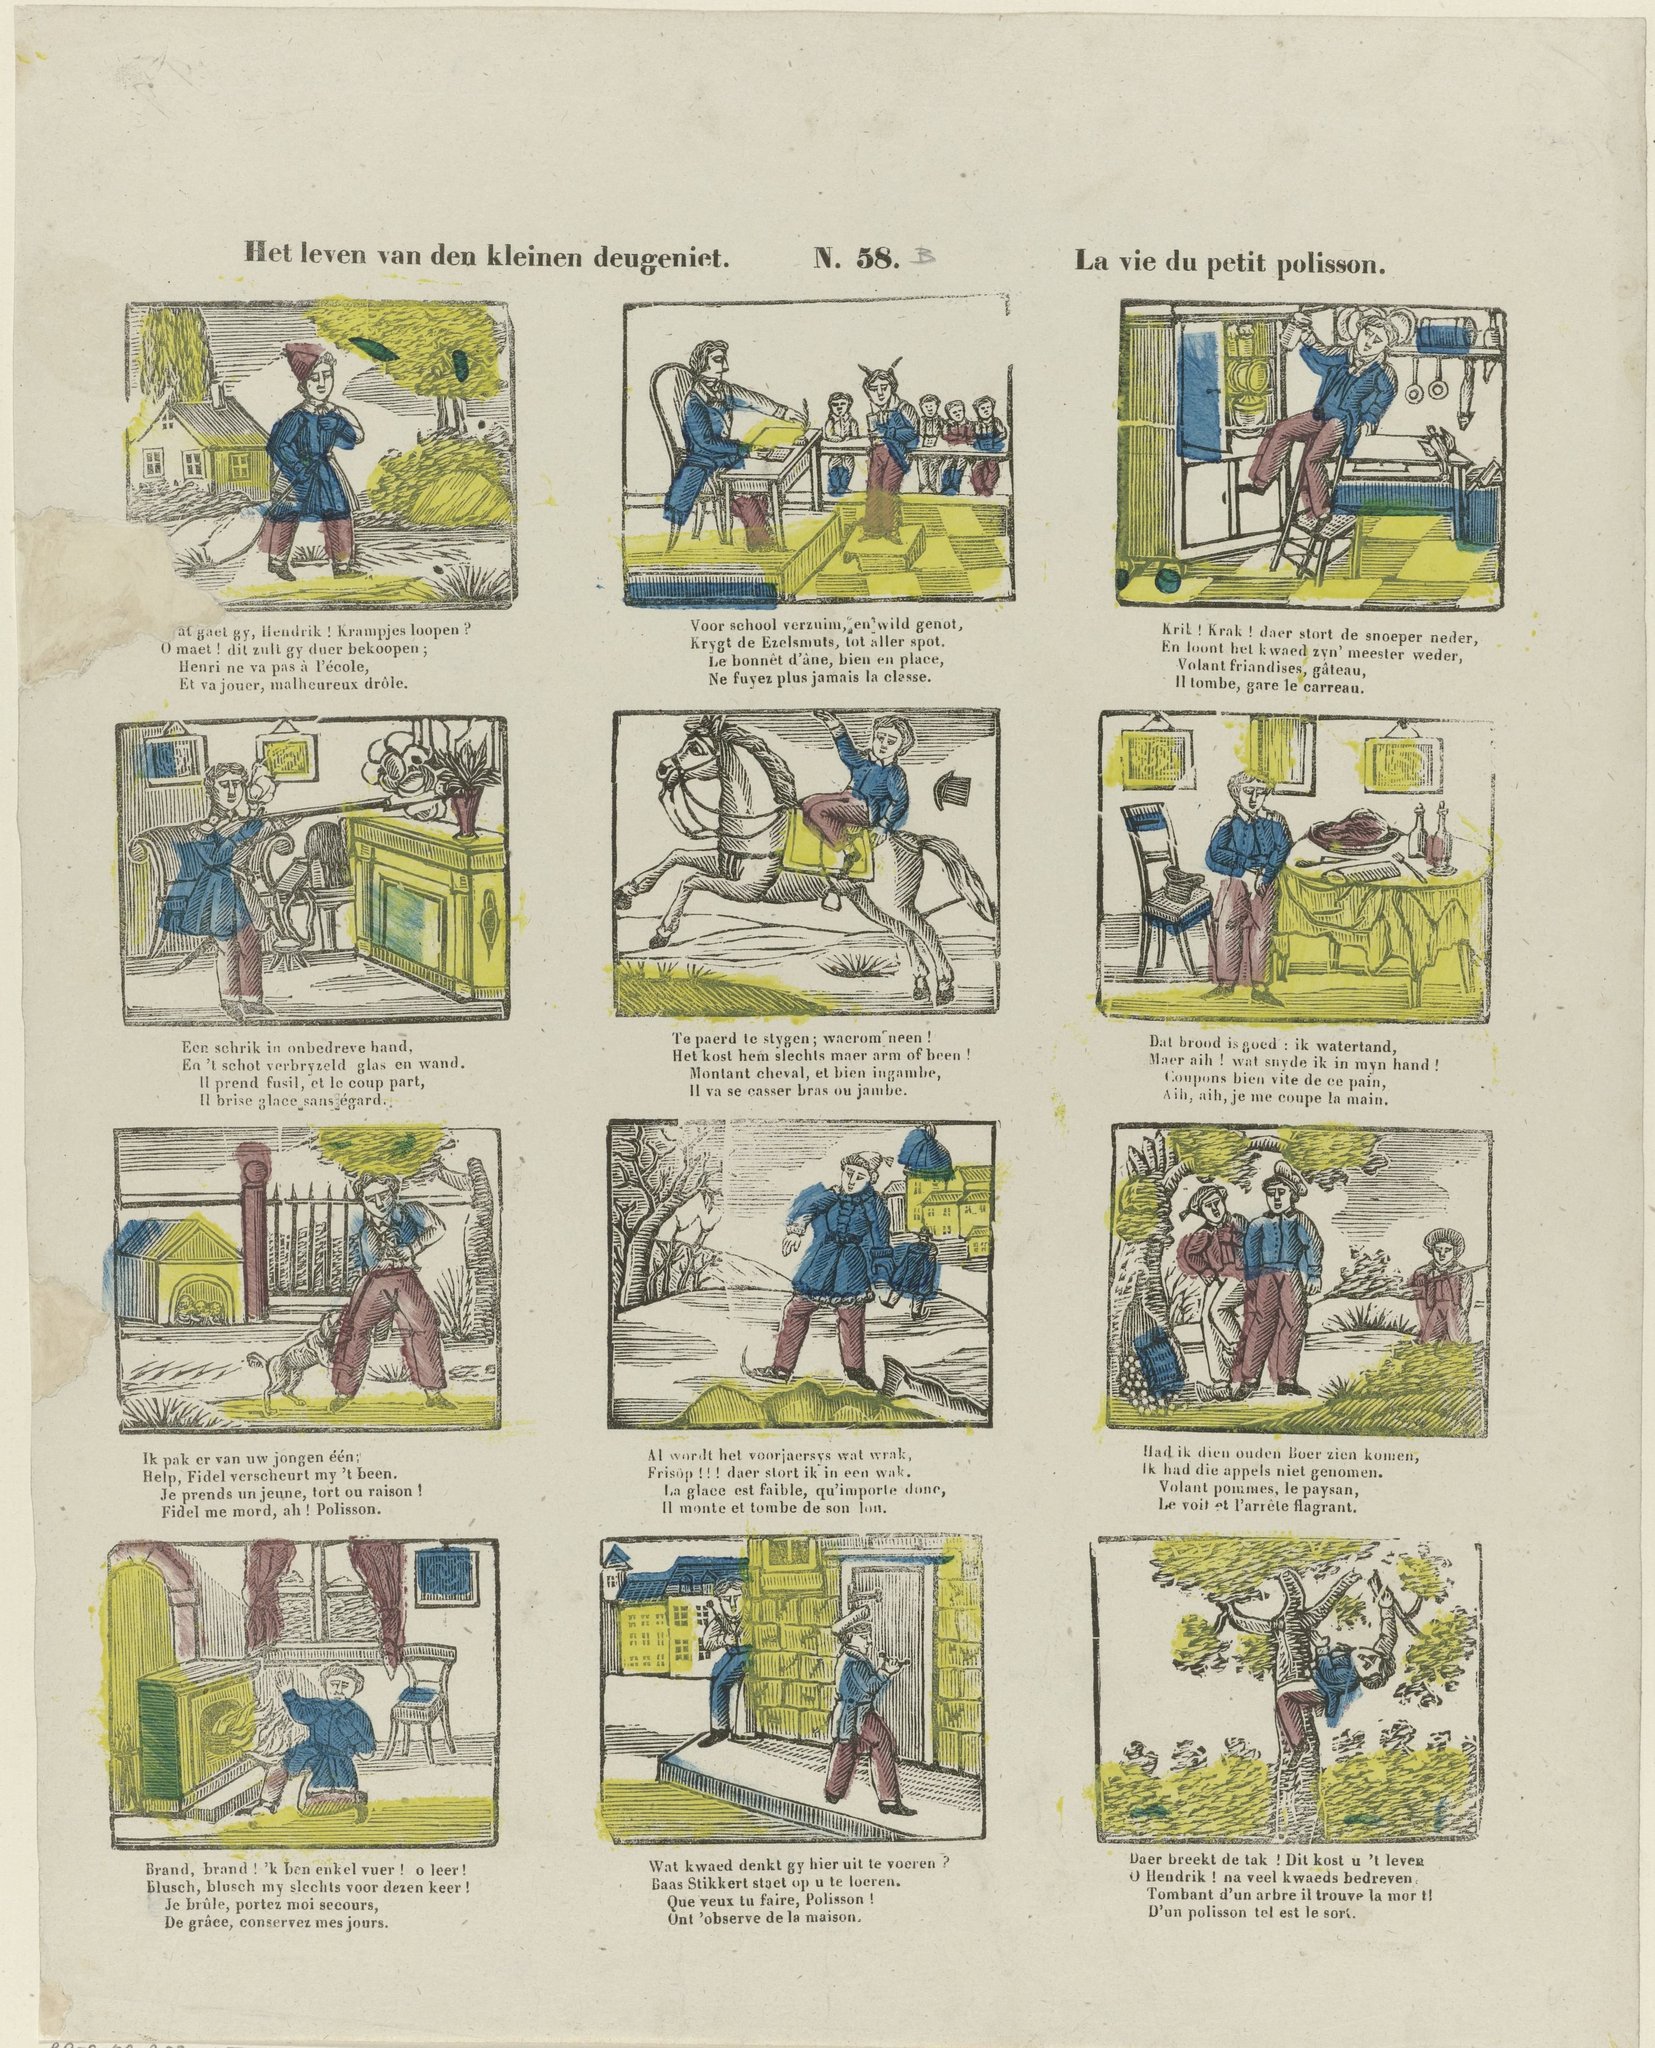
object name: print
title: Het leven van den kleinen deugniet / La vie du petit polisson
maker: Anonymous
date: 1833-1870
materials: paper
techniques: colour, letterpress printing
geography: netherlands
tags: mischief-making play, child, bad behaviour, little household accidents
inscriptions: collector's mark: Lugt 2760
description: Blad met 12 voorstellingen van de streken en ongelukken van de kleine deugniet Hendrik. Onder elke voorstelling een tweeregelig vers in het Nederlands en het Frans. Genummerd midden boven: N. 58.